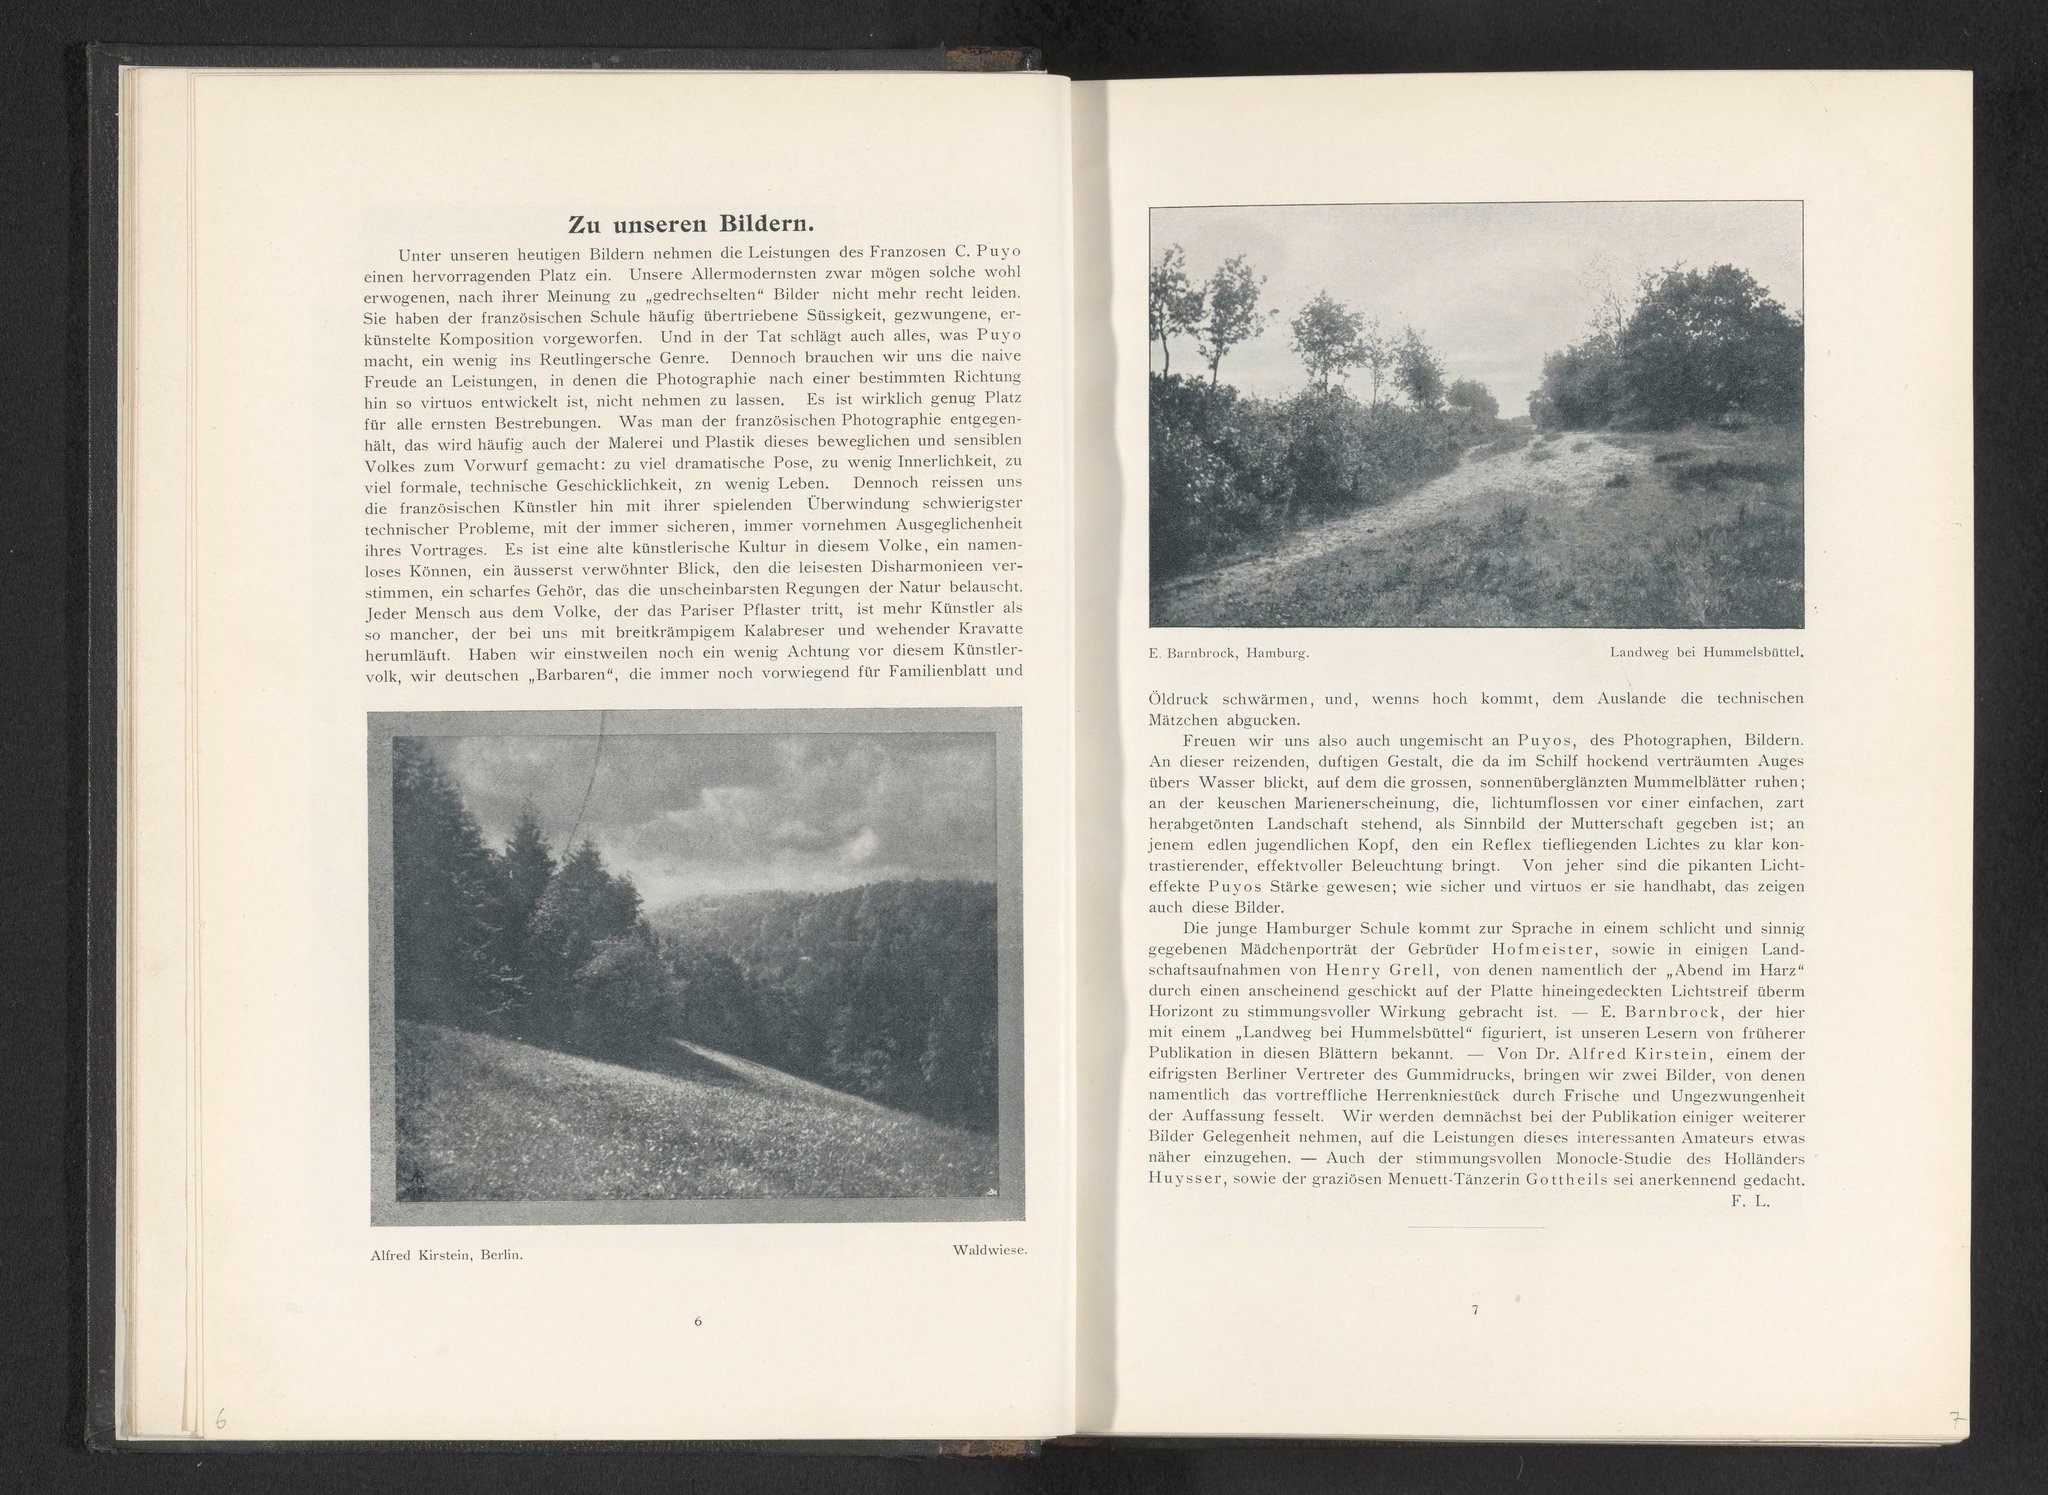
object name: page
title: Gezicht op een landweg nabij Hummelsbüttel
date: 1898-1903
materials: paper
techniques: autotype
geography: hamburg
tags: landscapes, road, path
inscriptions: monogram: ‘BX’